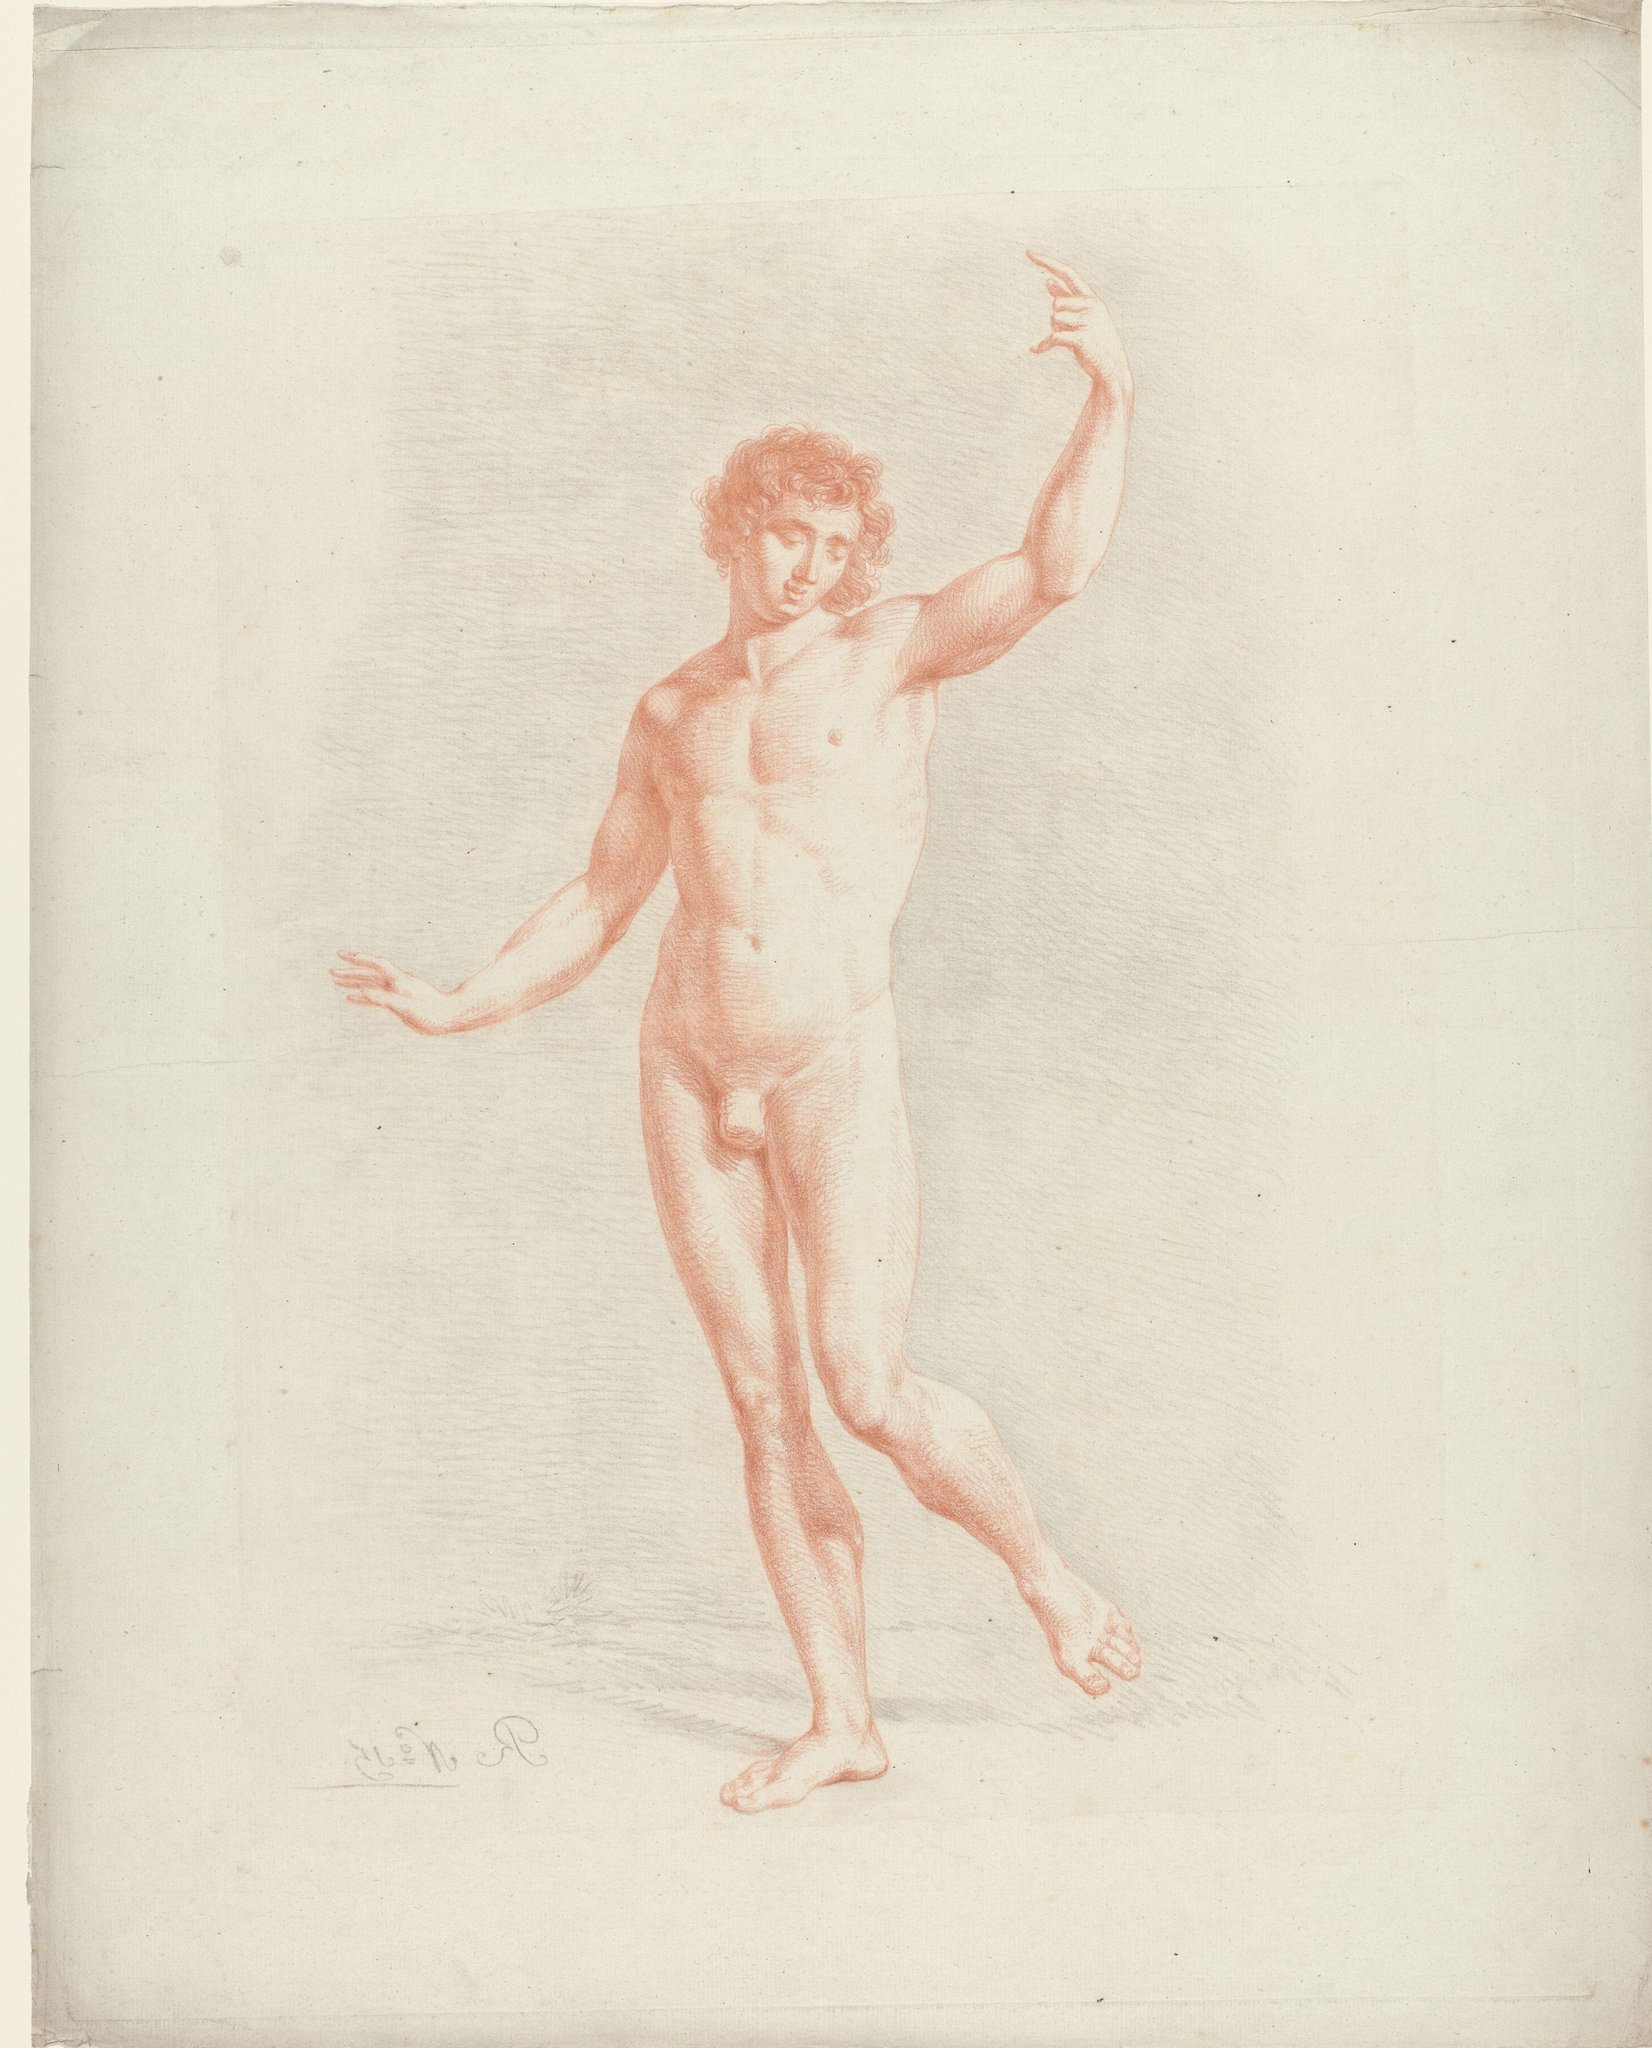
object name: drawing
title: Mannelijk naakt, staand op één been met opgeheven armen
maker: Anonymous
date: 1800-1900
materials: chalk, paper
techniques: printmaking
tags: standing figure